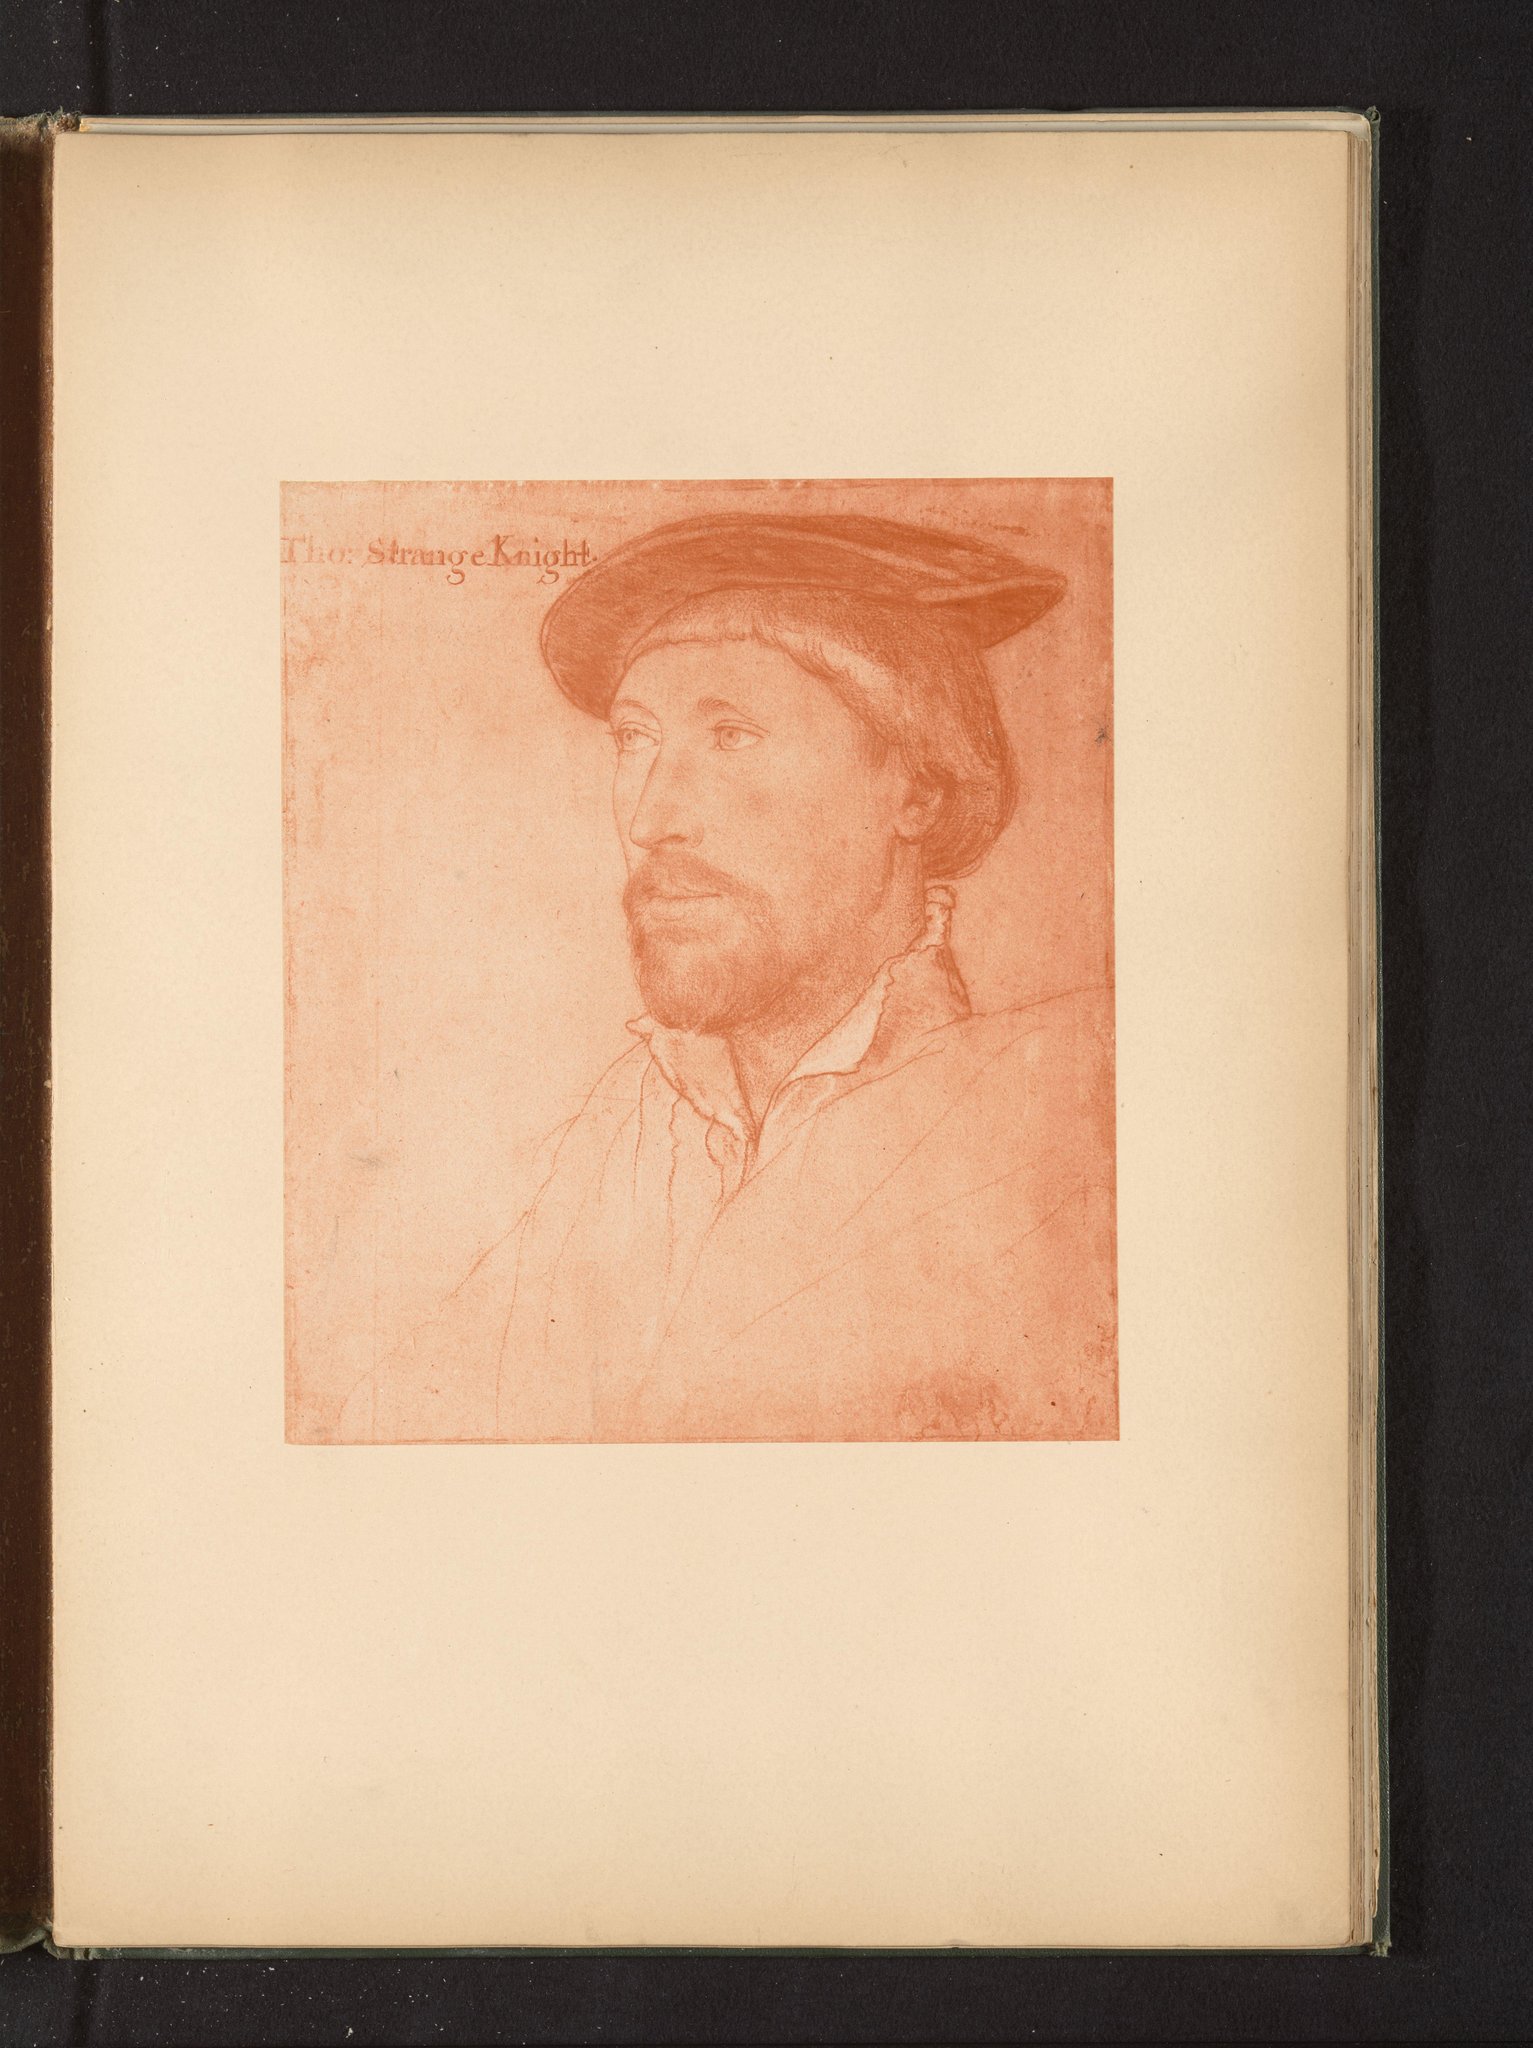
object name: photograph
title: Fotoreproductie van een portret van Thomas Lestrange door Hans Holbein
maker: Anonymous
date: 1872-1877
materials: paper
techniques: carbon print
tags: drawing, sketch, historical persons, royal household; courtiers, retinue, train